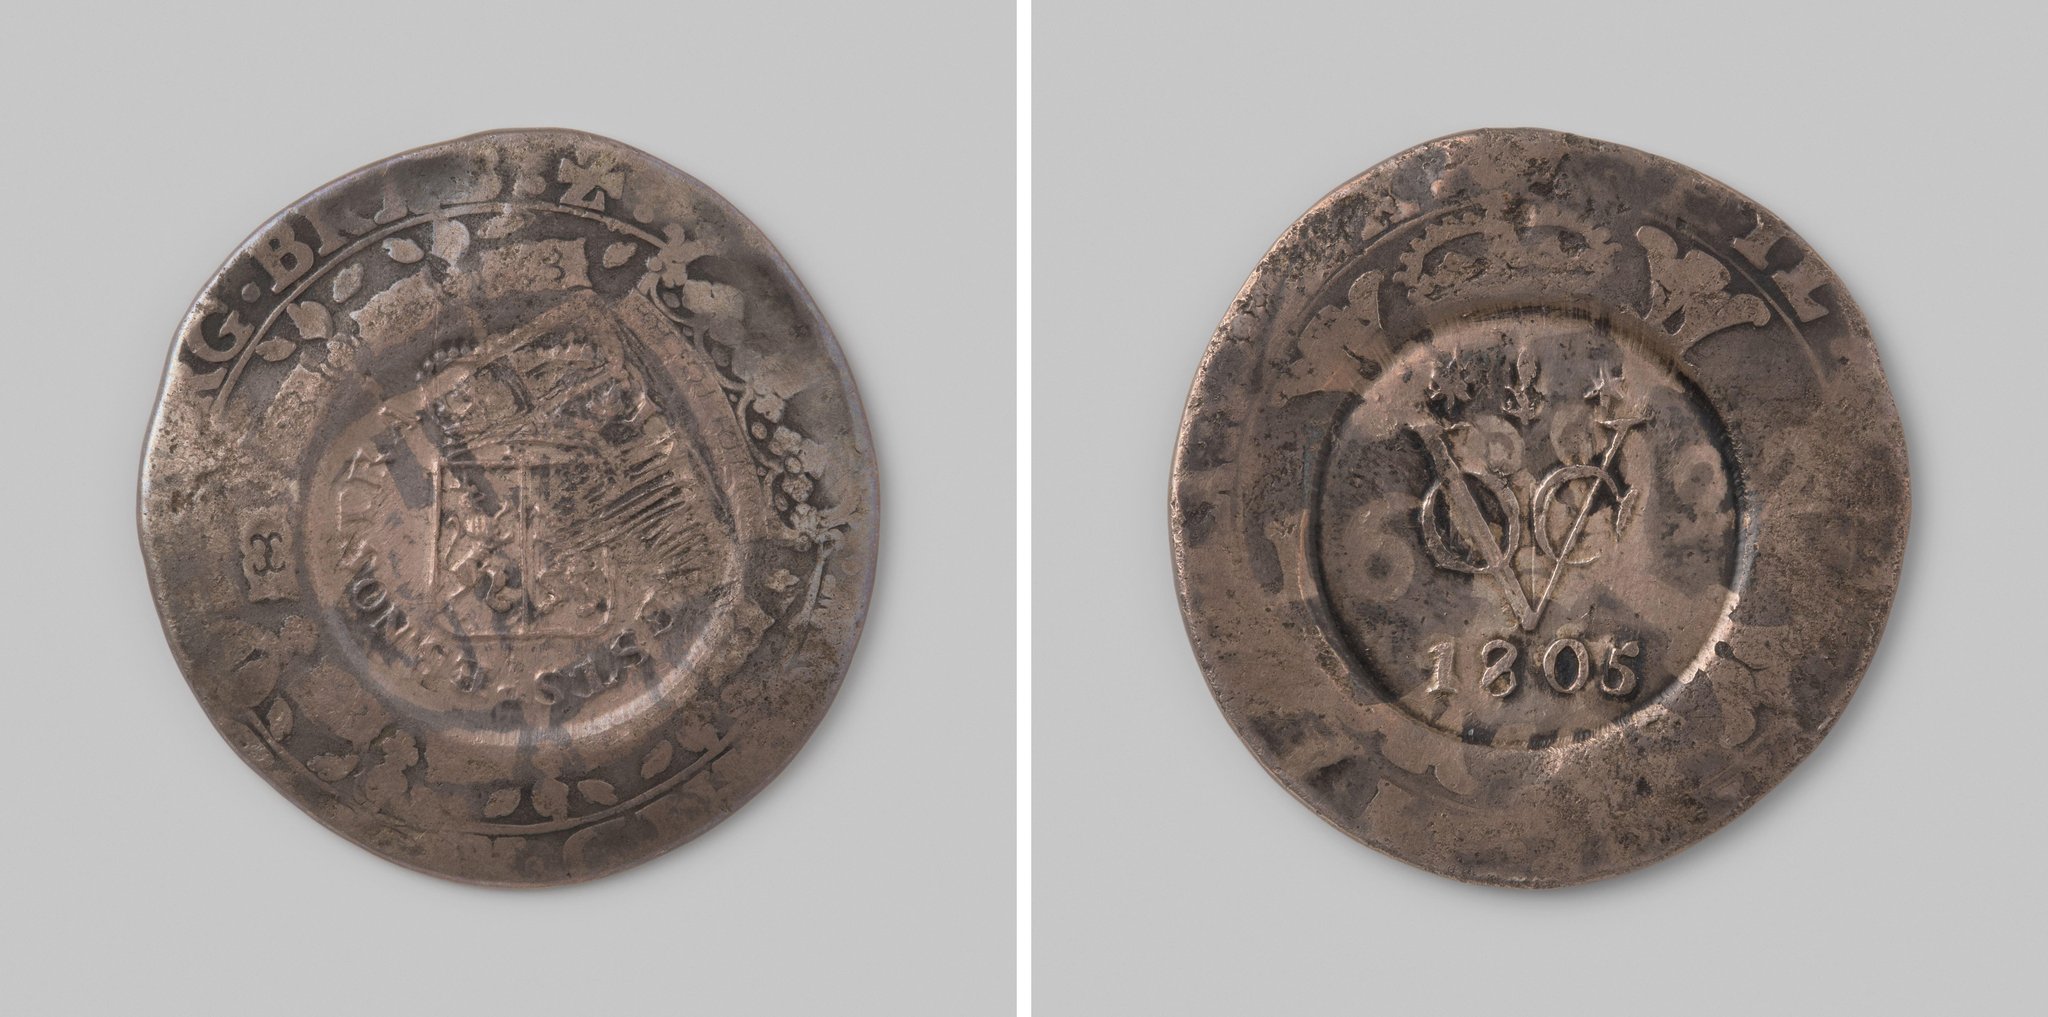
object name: coin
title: Afslag op zilveren Brabantse patagon uit 1622 van een duit voor Nederlands Indië uit Gelderland, 1805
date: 1805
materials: silver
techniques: striking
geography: harderwijk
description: Zilveren munt. Voorzijde: gekroond samengesteld Spaans wapenschild, waarop afslag van een Gelderse duit voor Nederlands Indië: tussen wapenspreuk gekroond wapenschild van Gelderland. Keerzijde: tussen jaartal: 1622 twee gekruiste stokken, waarboven kroon en waronder ramsvacht, Gulden Vlies. Daarop afslag van een Gelderse duit voor Nederlands Indië uit 1805: monogram van de VOC, waarboven muntmeesterteken en waaronder jaartal: 1805. Gladde rand.